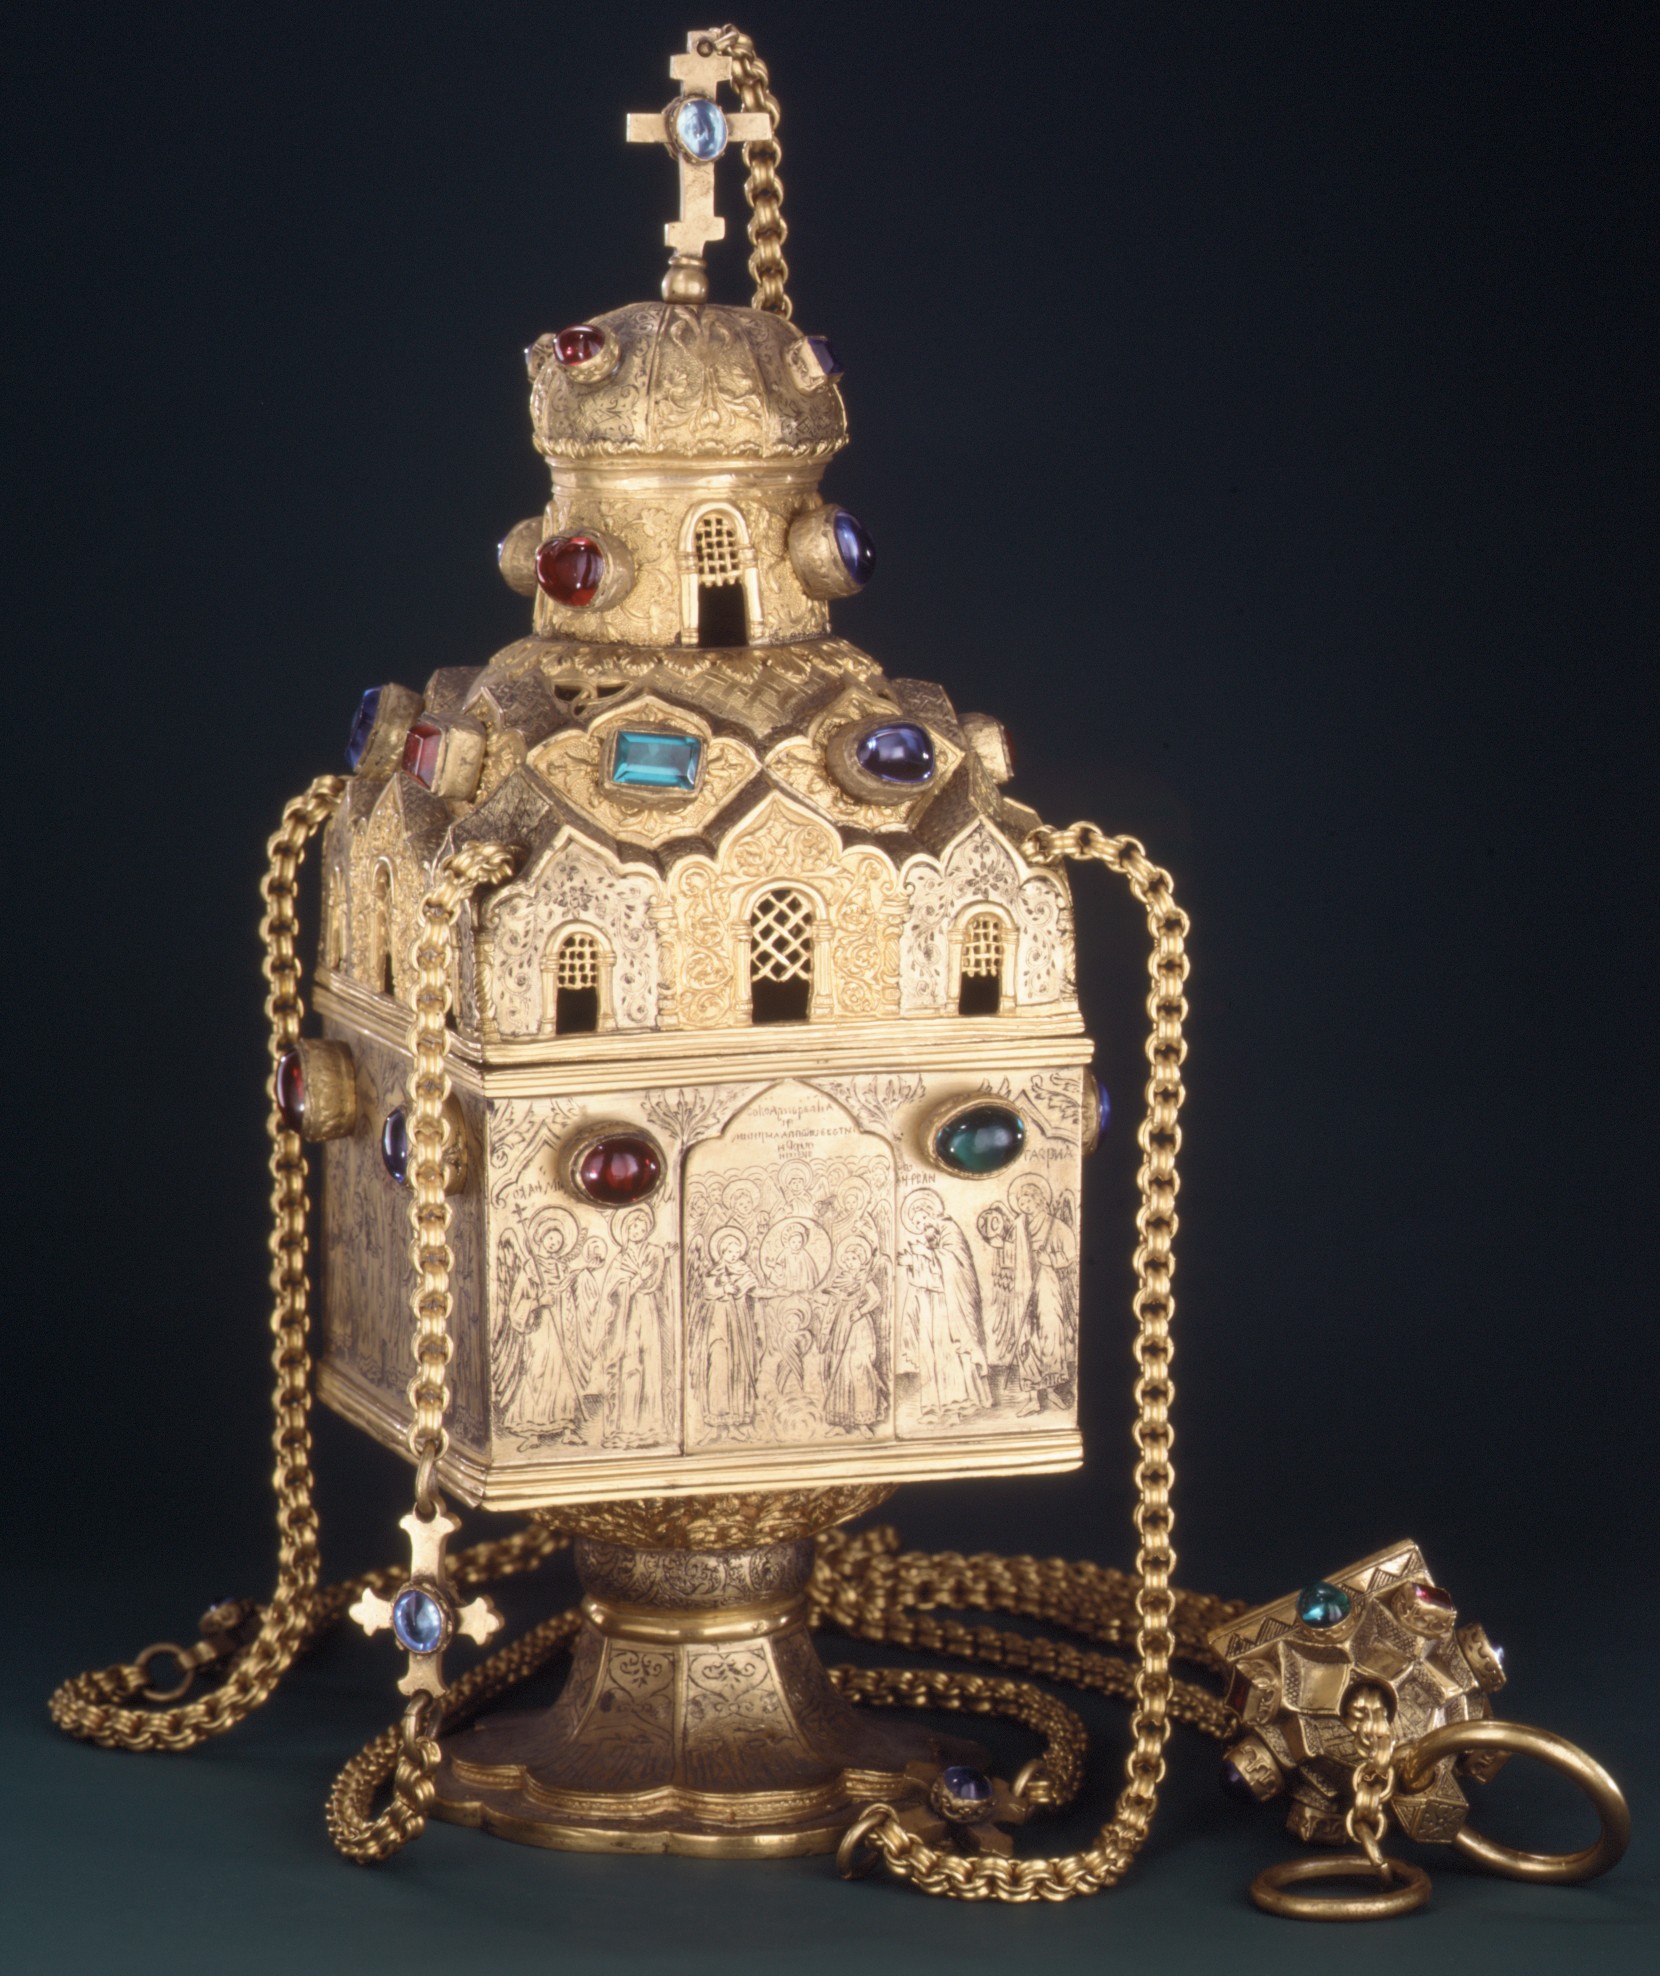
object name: censer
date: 1801-1900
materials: gold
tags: women,angels,cross,censers